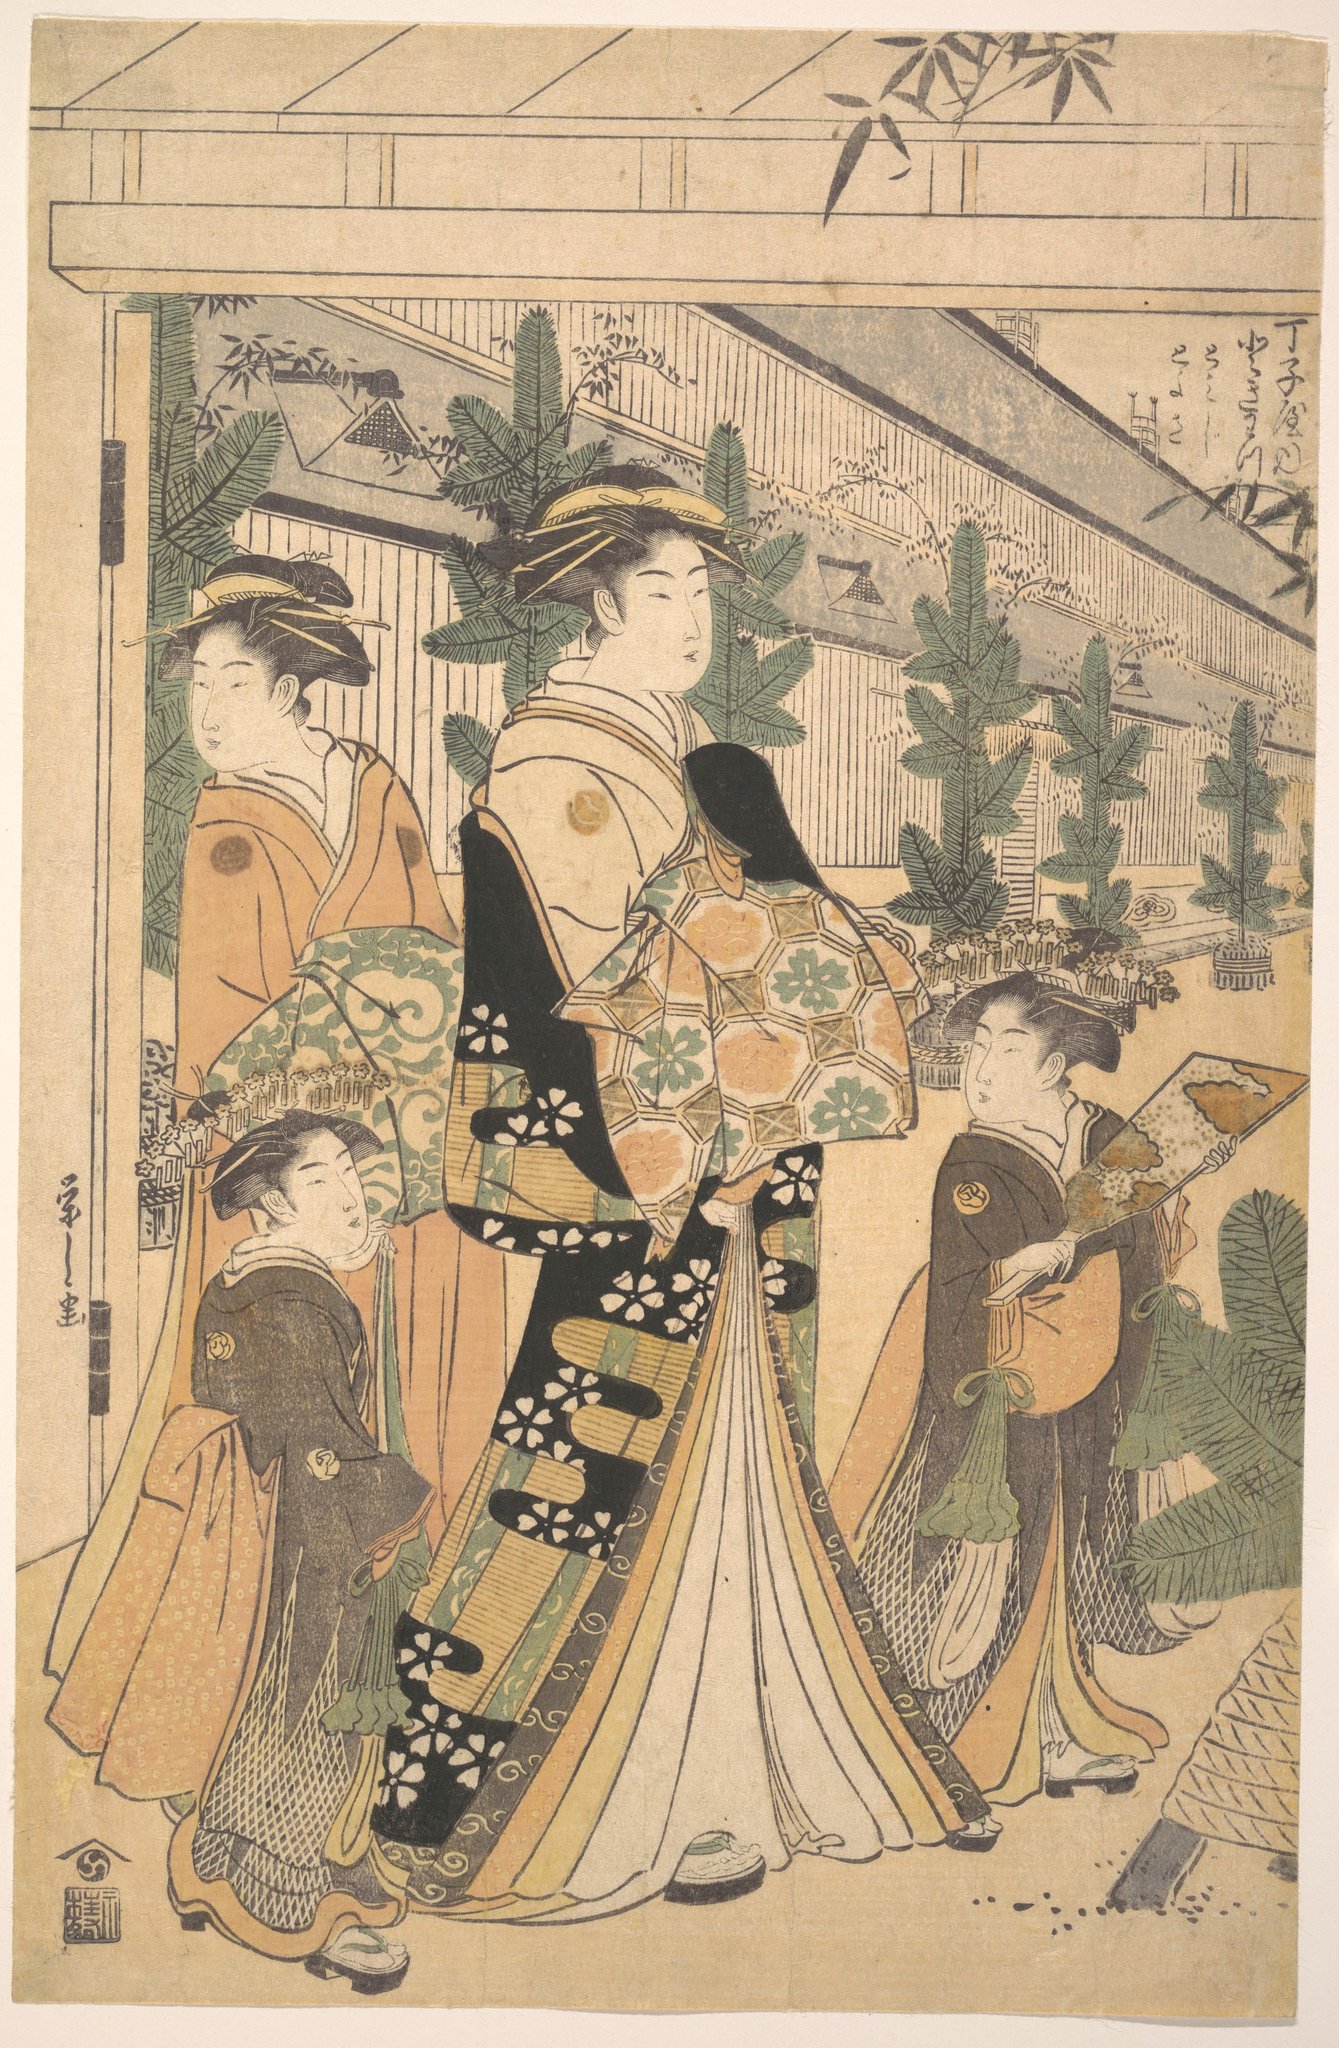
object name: print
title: Two Oiran with Two Female Attendants in the Yoshiwara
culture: japanese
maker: chōbunsai eishi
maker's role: artist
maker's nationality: japanese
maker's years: 1756-1829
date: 1756-1829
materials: ink, paper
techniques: woodblock print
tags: women